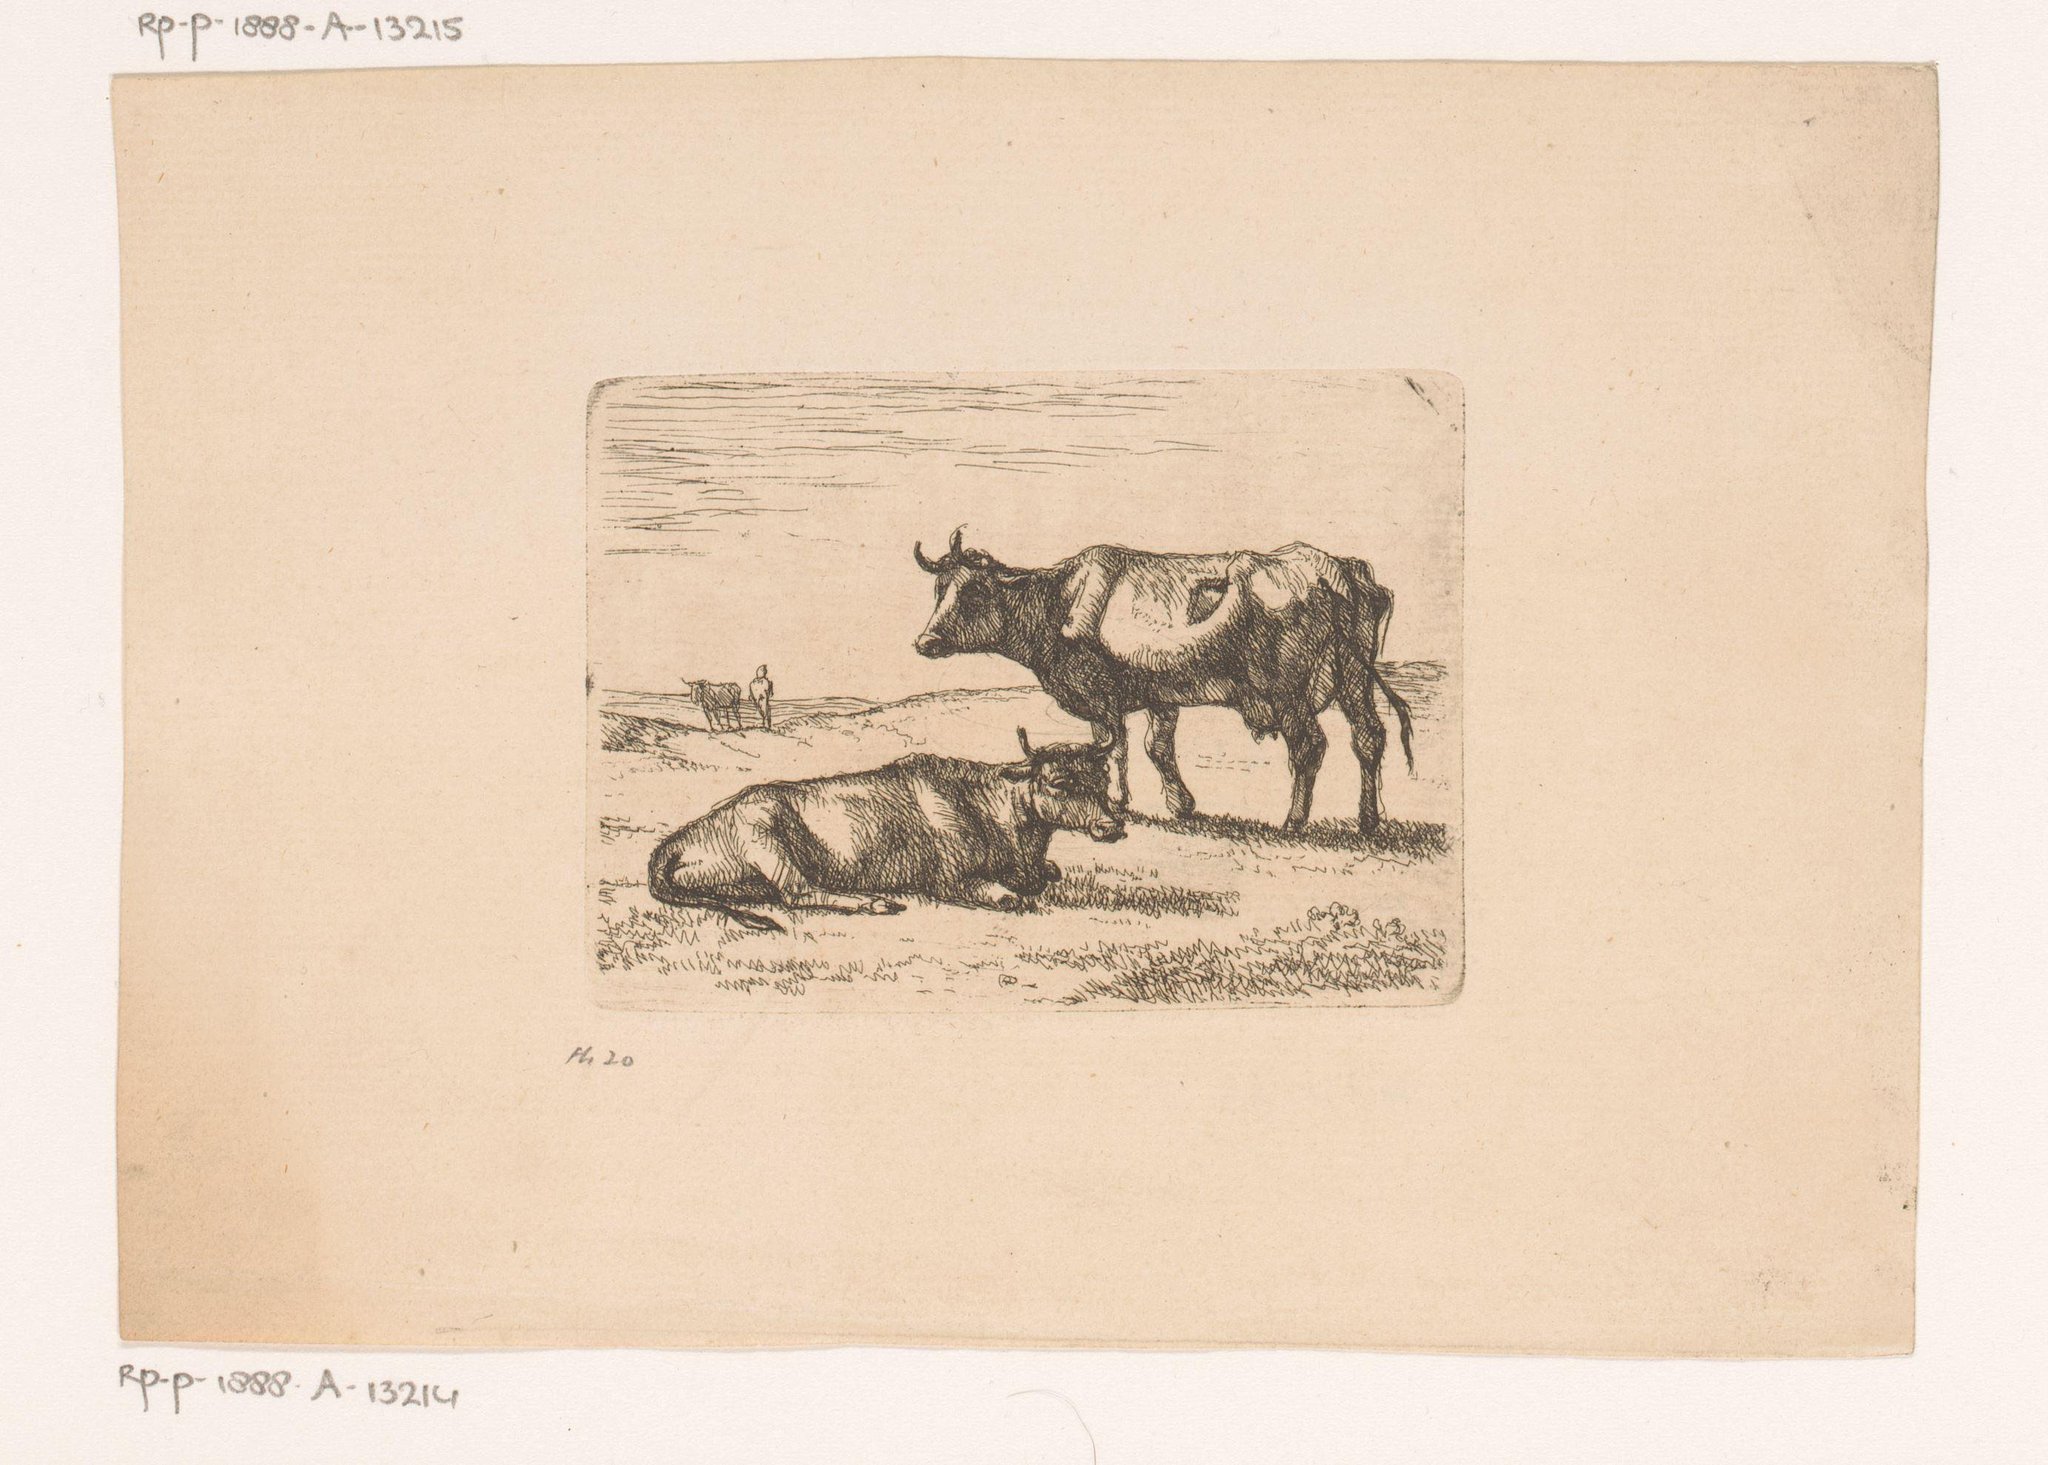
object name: print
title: Twee runderen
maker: hendrik jozef franciscus van der poorten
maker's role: draughtsman, print maker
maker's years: 1789-1874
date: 1799-1874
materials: paper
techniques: etching, intaglio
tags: bovine cattle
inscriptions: collector's mark: Lugt 2228